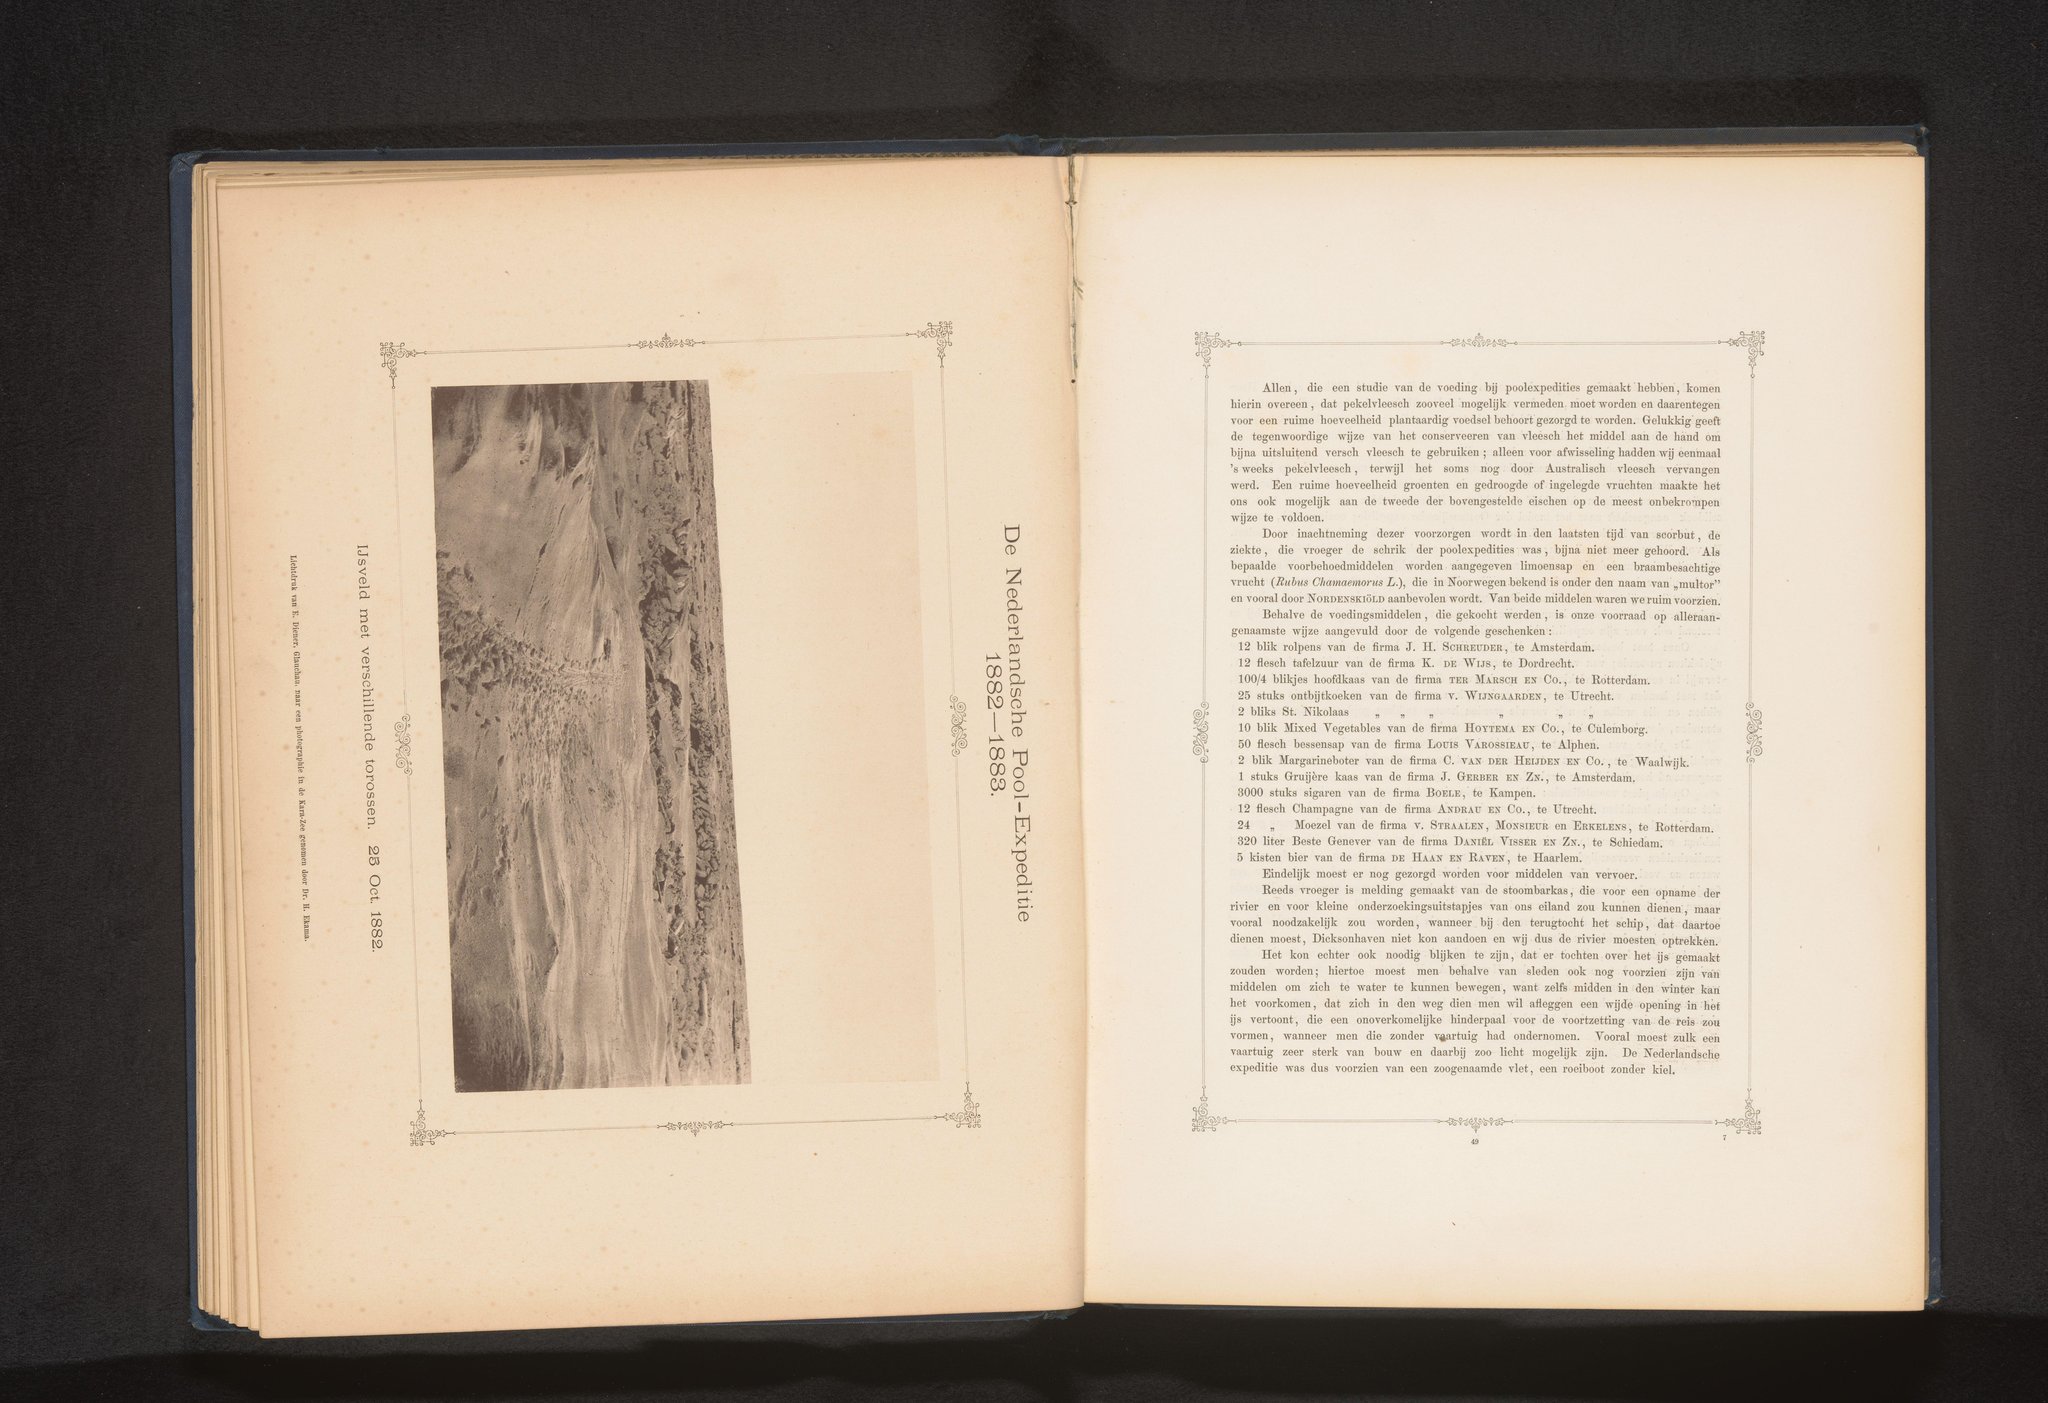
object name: page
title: Gezicht op torossen in de Karazee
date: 1881-1886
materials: paper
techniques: photograph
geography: glauchau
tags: icefield, landscapes in polar regions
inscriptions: inscription: ‘De Nederlandsche Pool-Expeditie 1882-1883.’